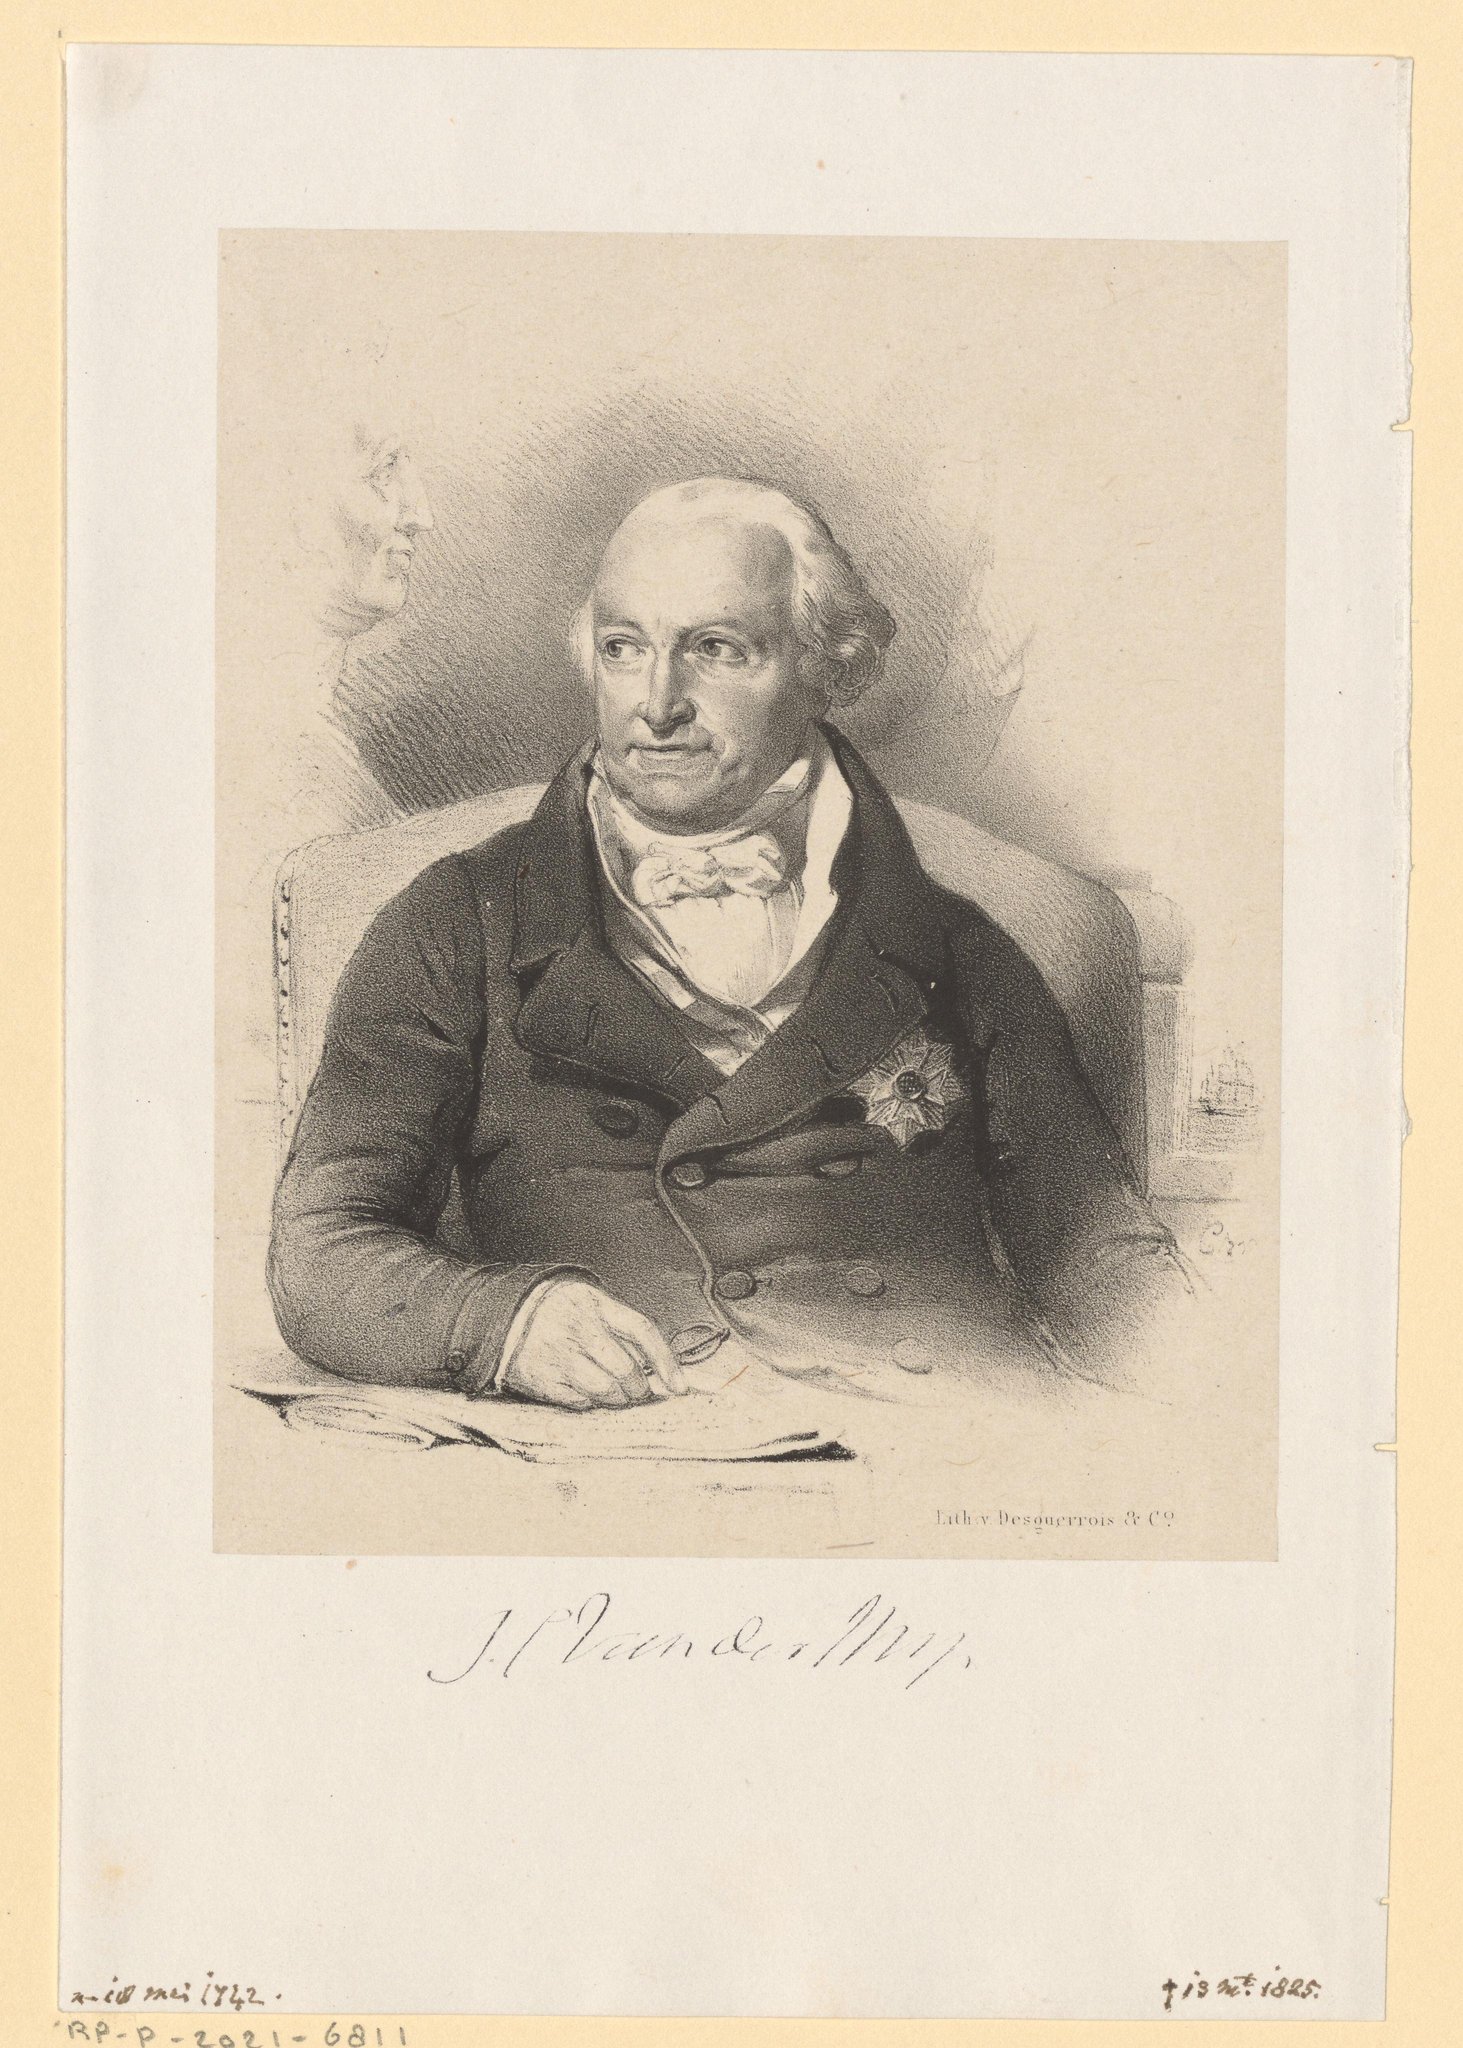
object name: print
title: Portret van Johan Cornelis van der Hoop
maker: Anonymous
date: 1827-1850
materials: paper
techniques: lithograph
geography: amsterdam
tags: the hague, historical persons, politician, e.g. party leader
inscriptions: inscription: ‘n. 18 mei 1747 + 13 m[aart] 1825’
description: Op het opzetvel is een strook papier geplakt met wat biografische gegevens, met de hand geschreven.